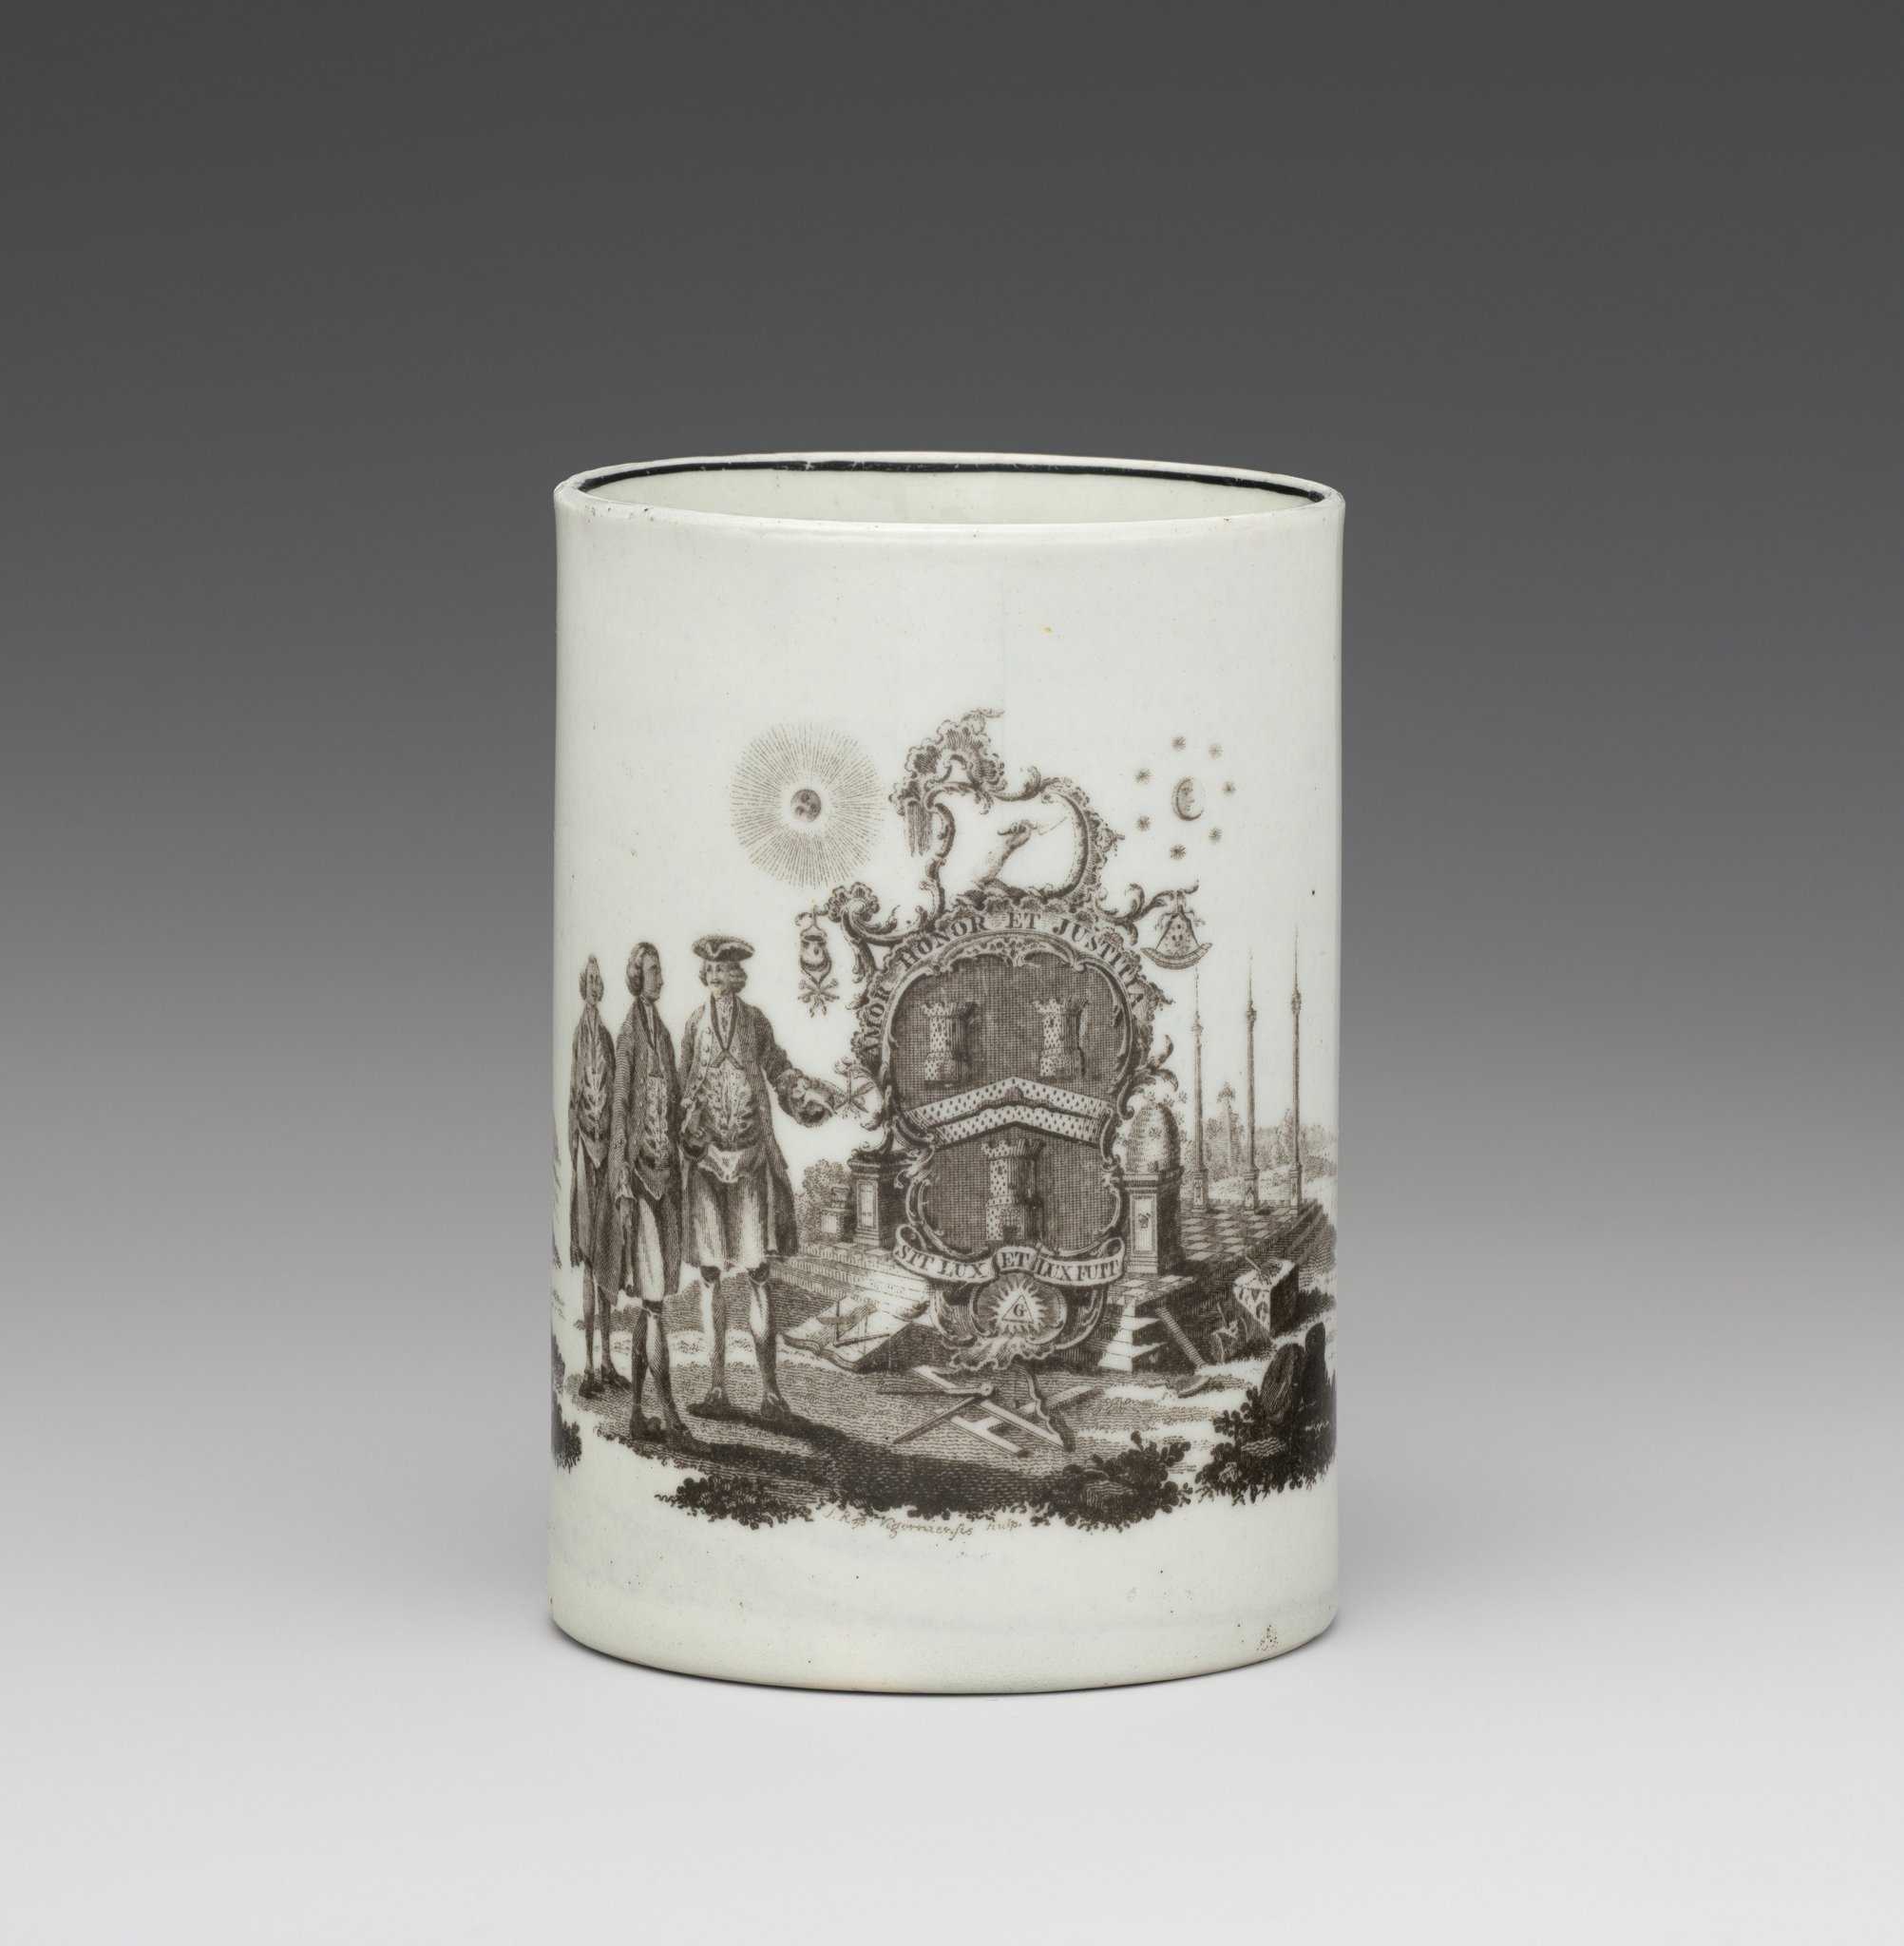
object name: mug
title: Mug with Freemason symbols and motto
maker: worcester factory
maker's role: factory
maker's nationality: british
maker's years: 1751-2008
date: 1765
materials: soft paste porcelain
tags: coat of arms